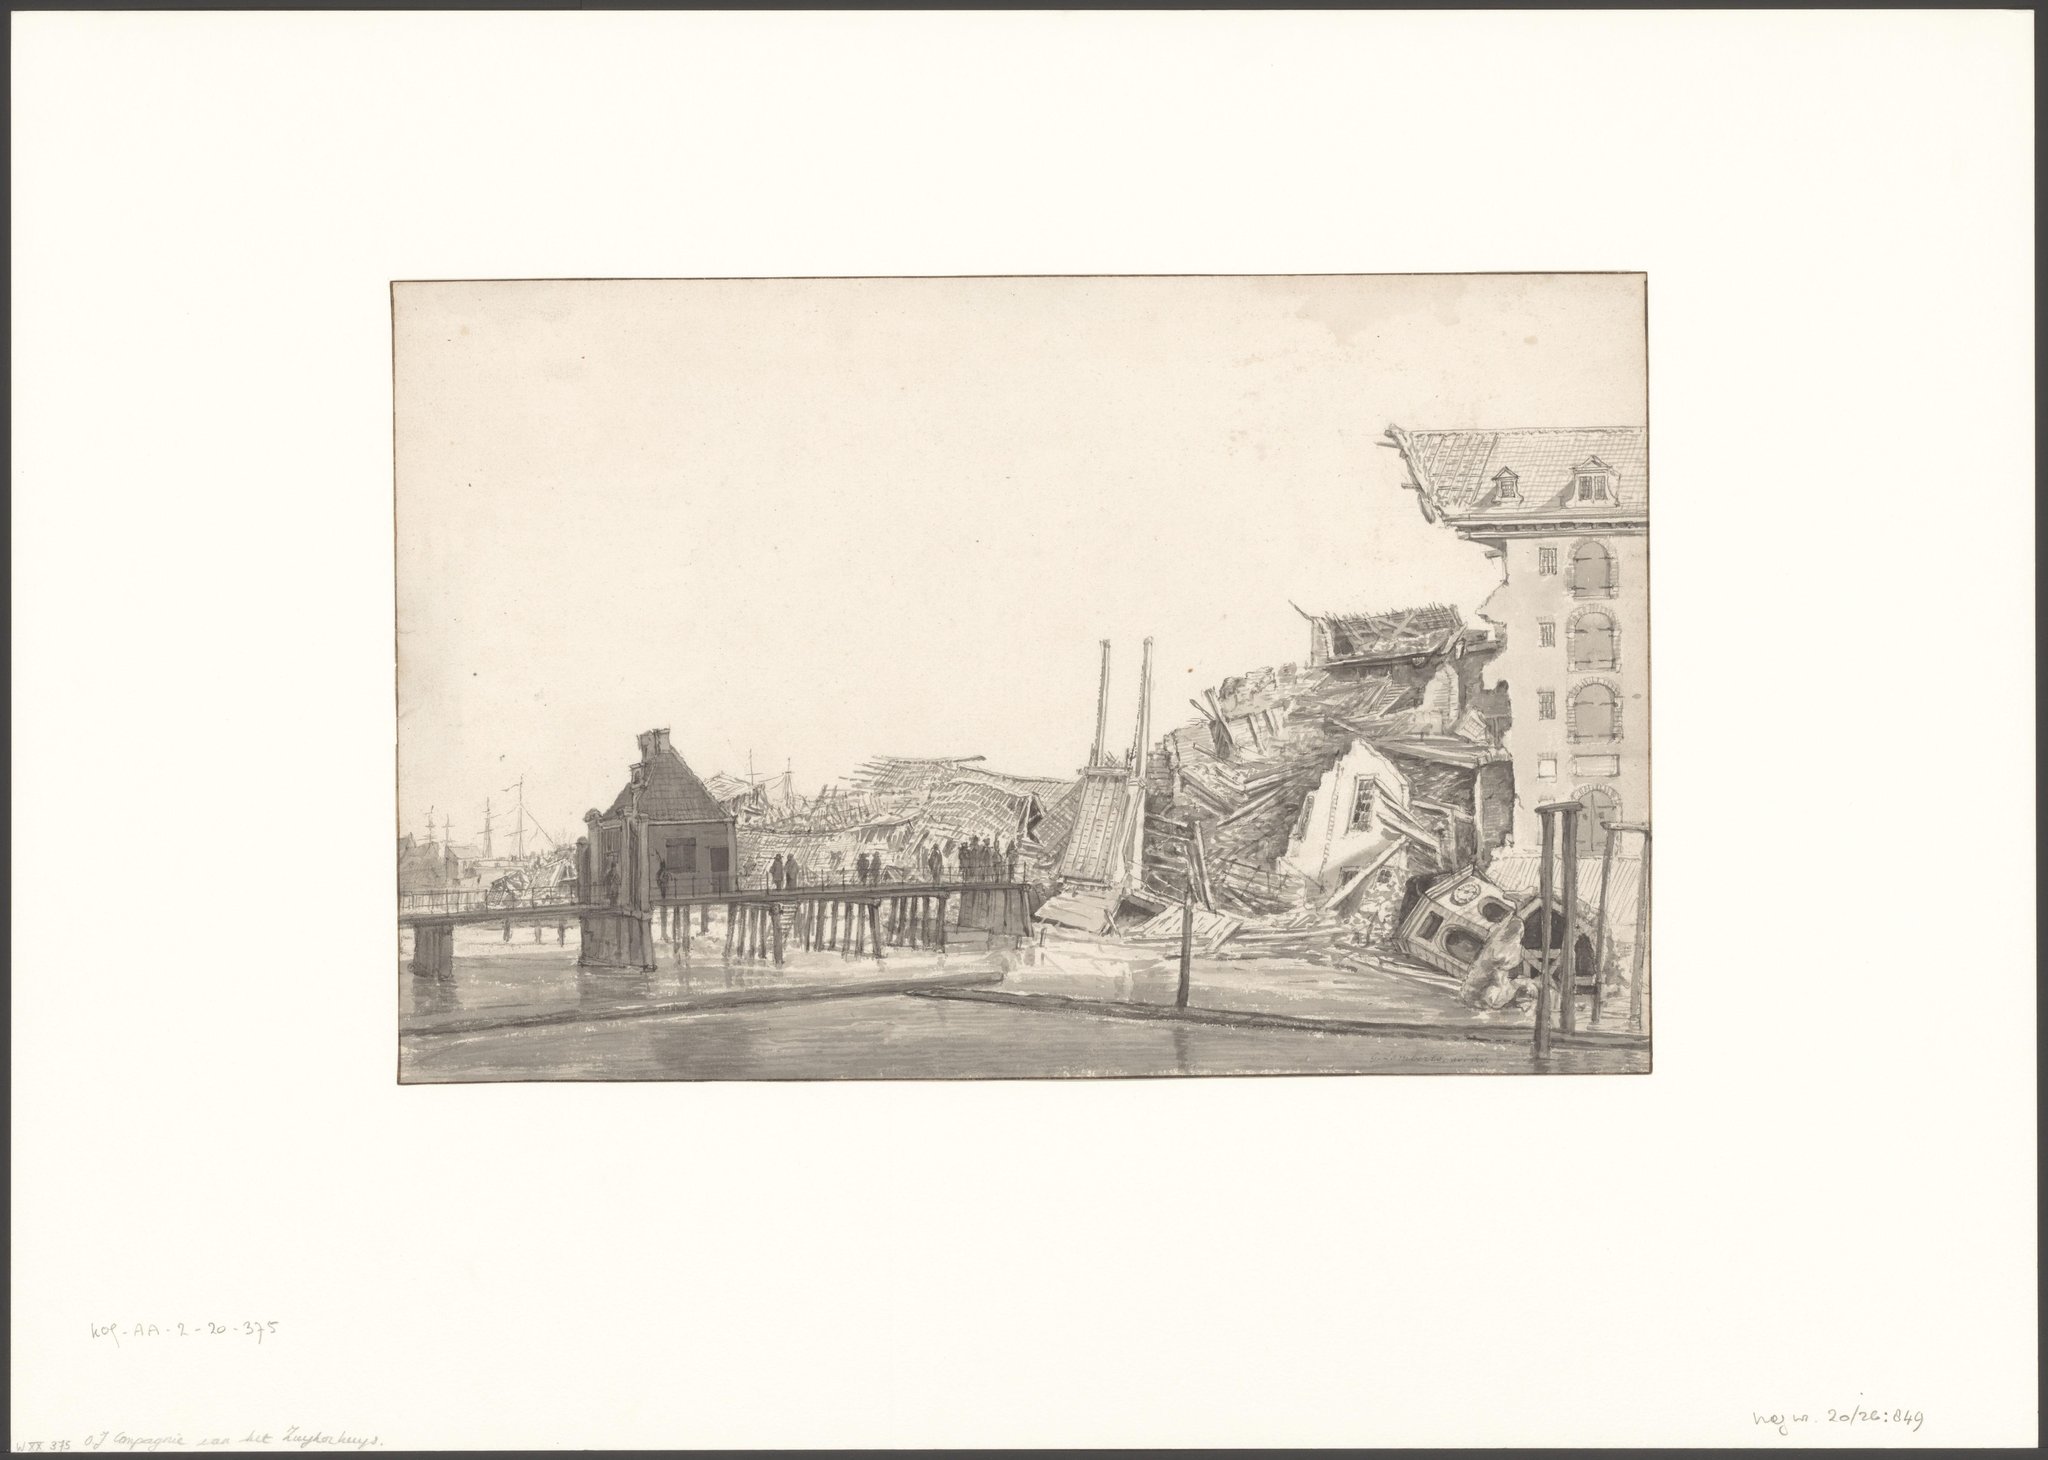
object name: drawing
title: Gezicht op het Oost-Indisch Zeemagazijn na de instorting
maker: gerrit lamberts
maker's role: bookseller, draughtsman, print maker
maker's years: 1776-1850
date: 1822-1829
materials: chalk, ink, paper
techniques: brush, pen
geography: amsterdam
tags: large-scale structure for storage, e.g.: warehouse, depot, silo, city-view in general; 'veduta', canal, bridge in city across river, canal, etc., ruin of a dwelling, house, castle, etc.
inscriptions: inscription: ‘N4 de Oost: Compagnie van het Zuyder huys’, signature: ‘G.Lamberts.ad.viv.’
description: Tekening binnen de Atlas Van Eck ingedeeld op wijknummer 20.